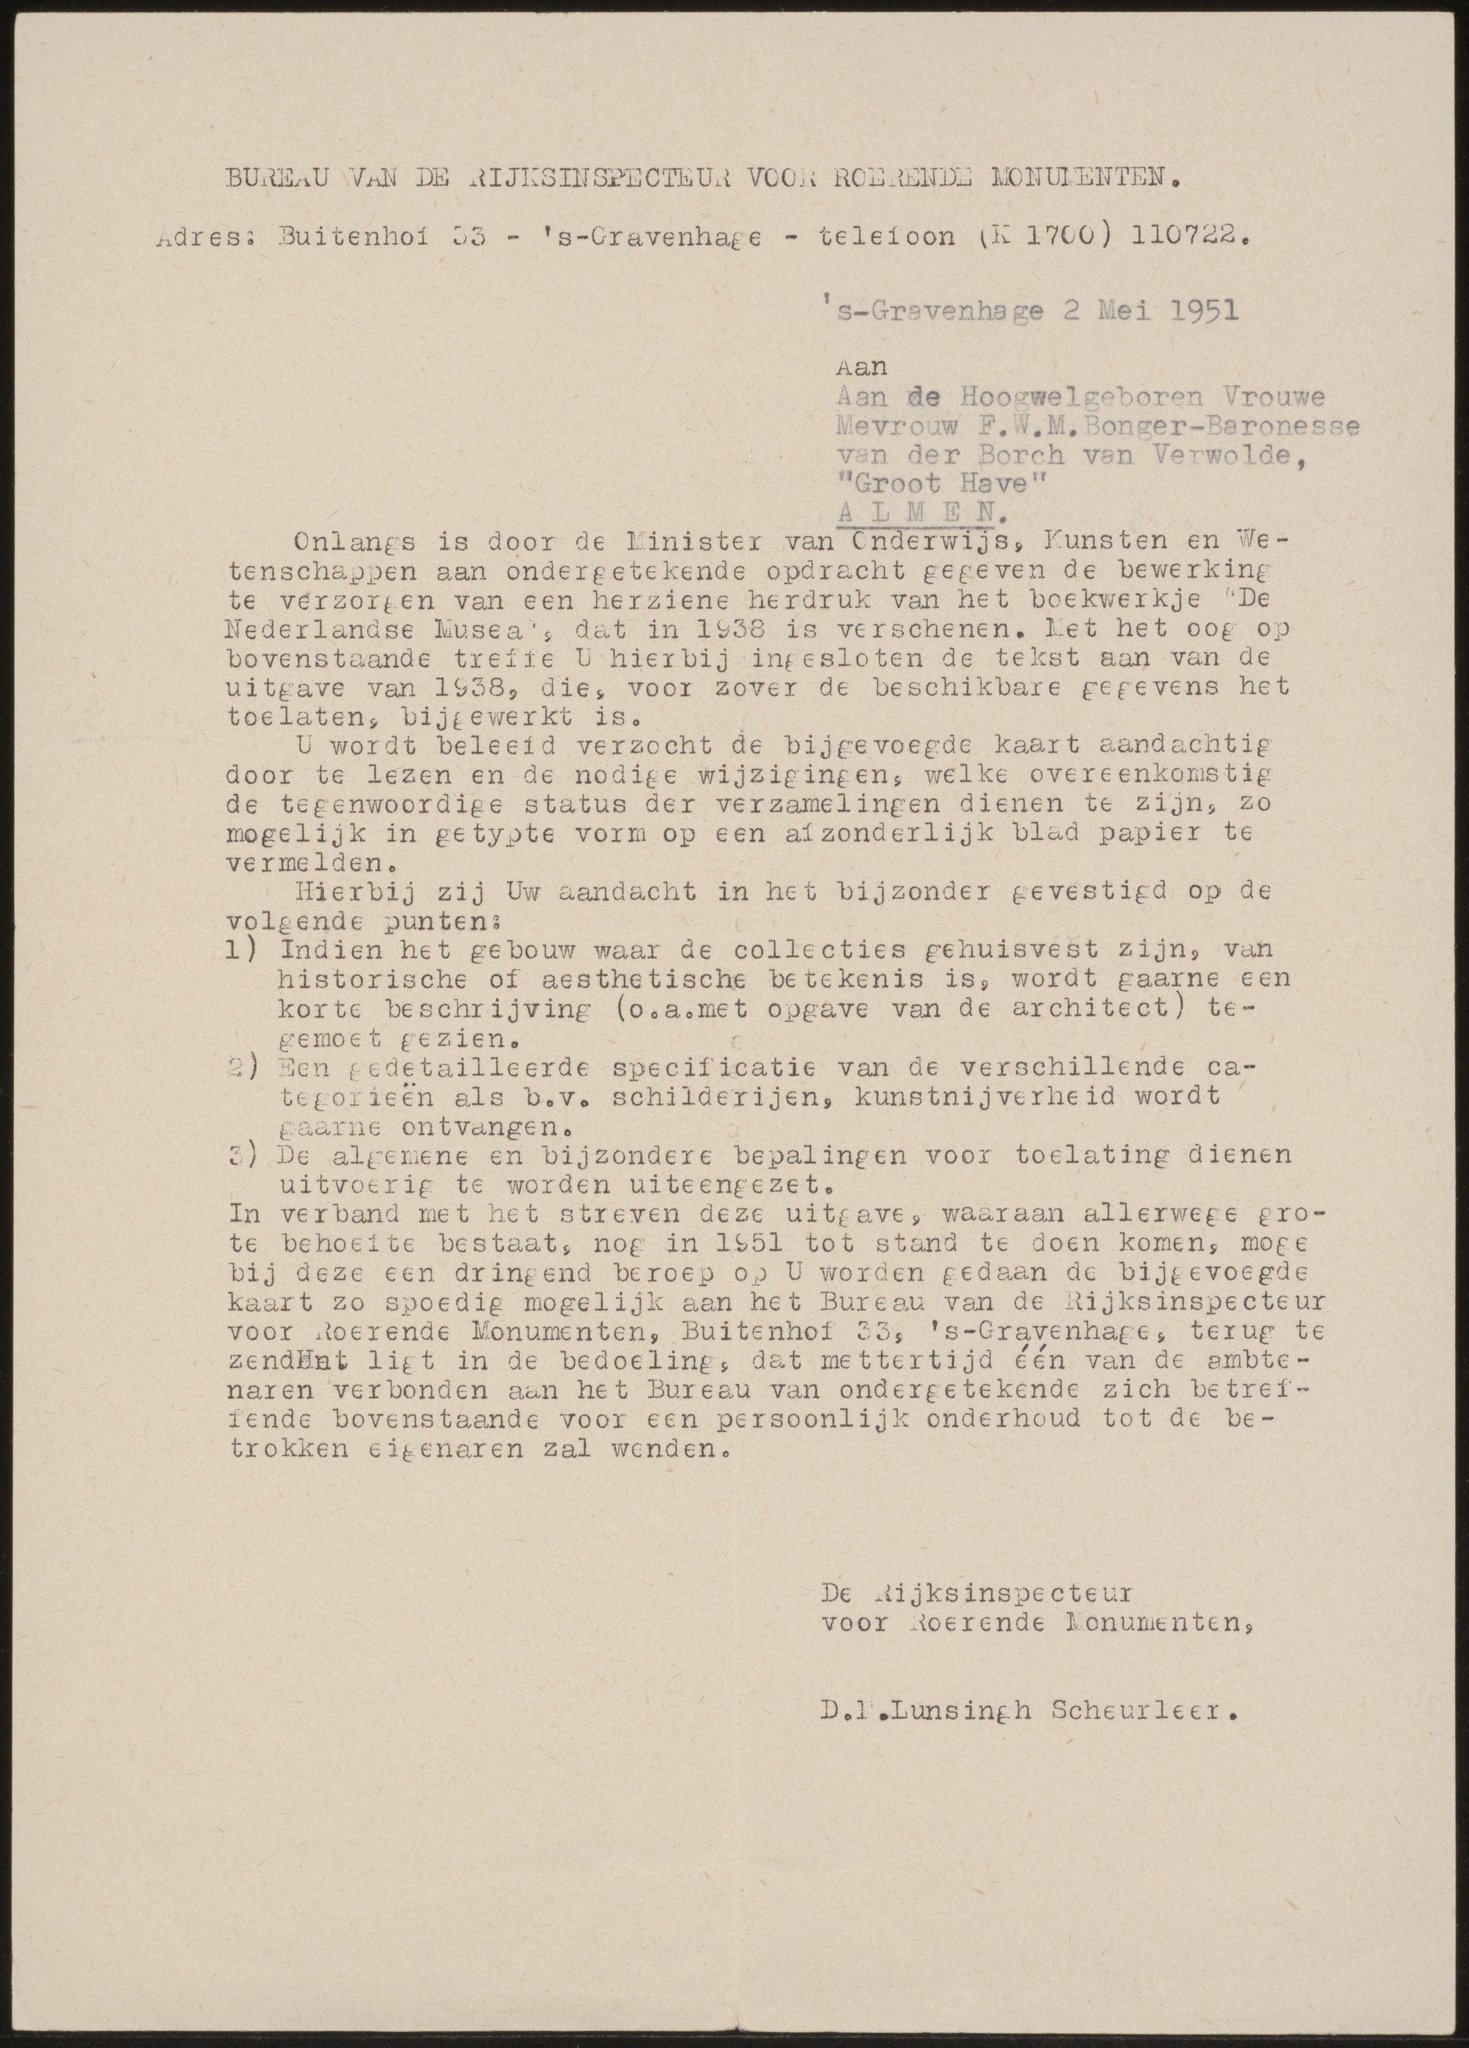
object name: letter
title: Brief aan Françoise W.M. Bonger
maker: daniël françois lunsingh scheurleer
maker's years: 1855-1927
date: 1951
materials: ink, paper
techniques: typewriting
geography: the hague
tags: françoise w.m. bonger